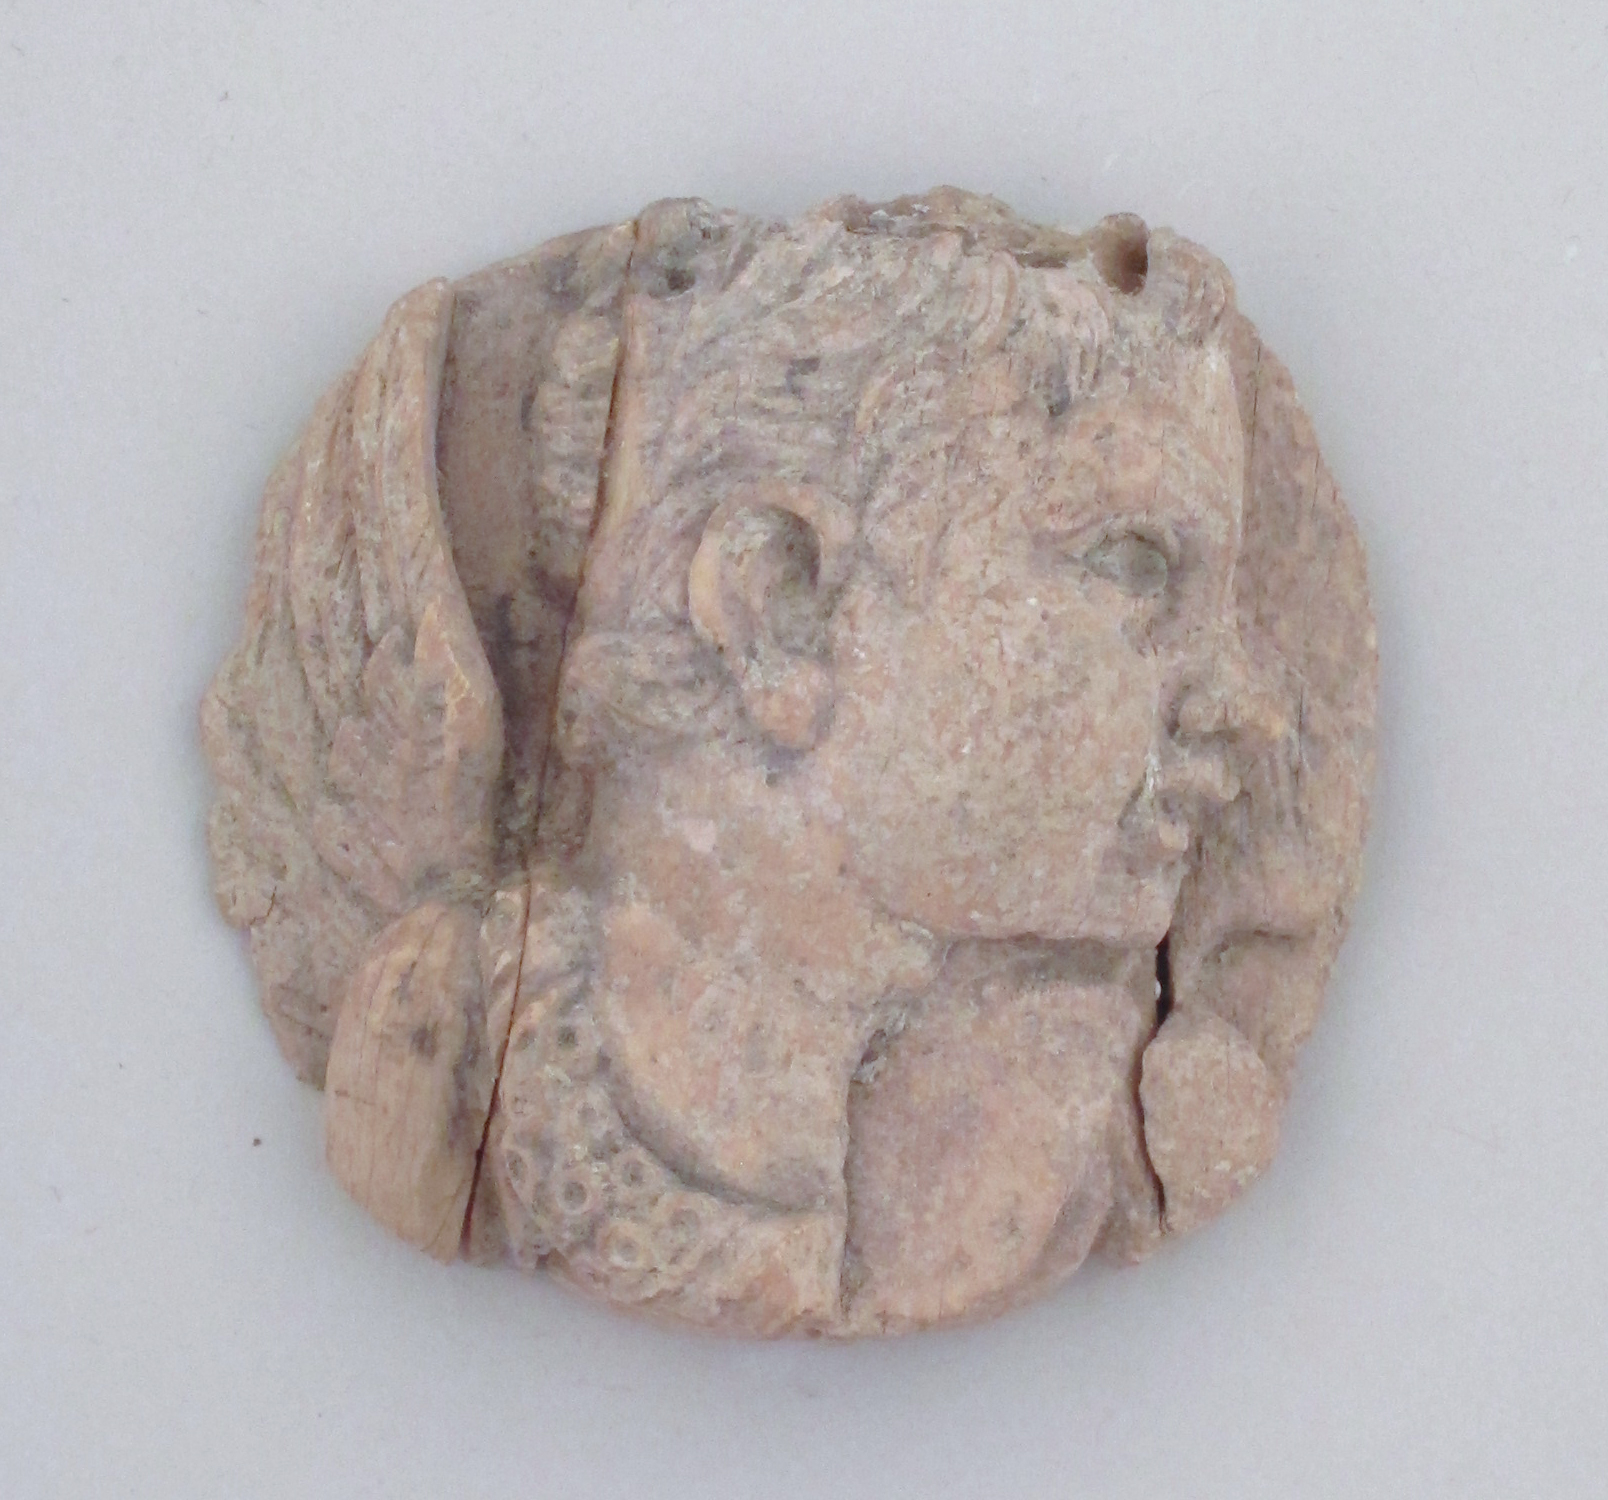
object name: relief of eros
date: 7000 BCE-330 CE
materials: bone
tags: eros